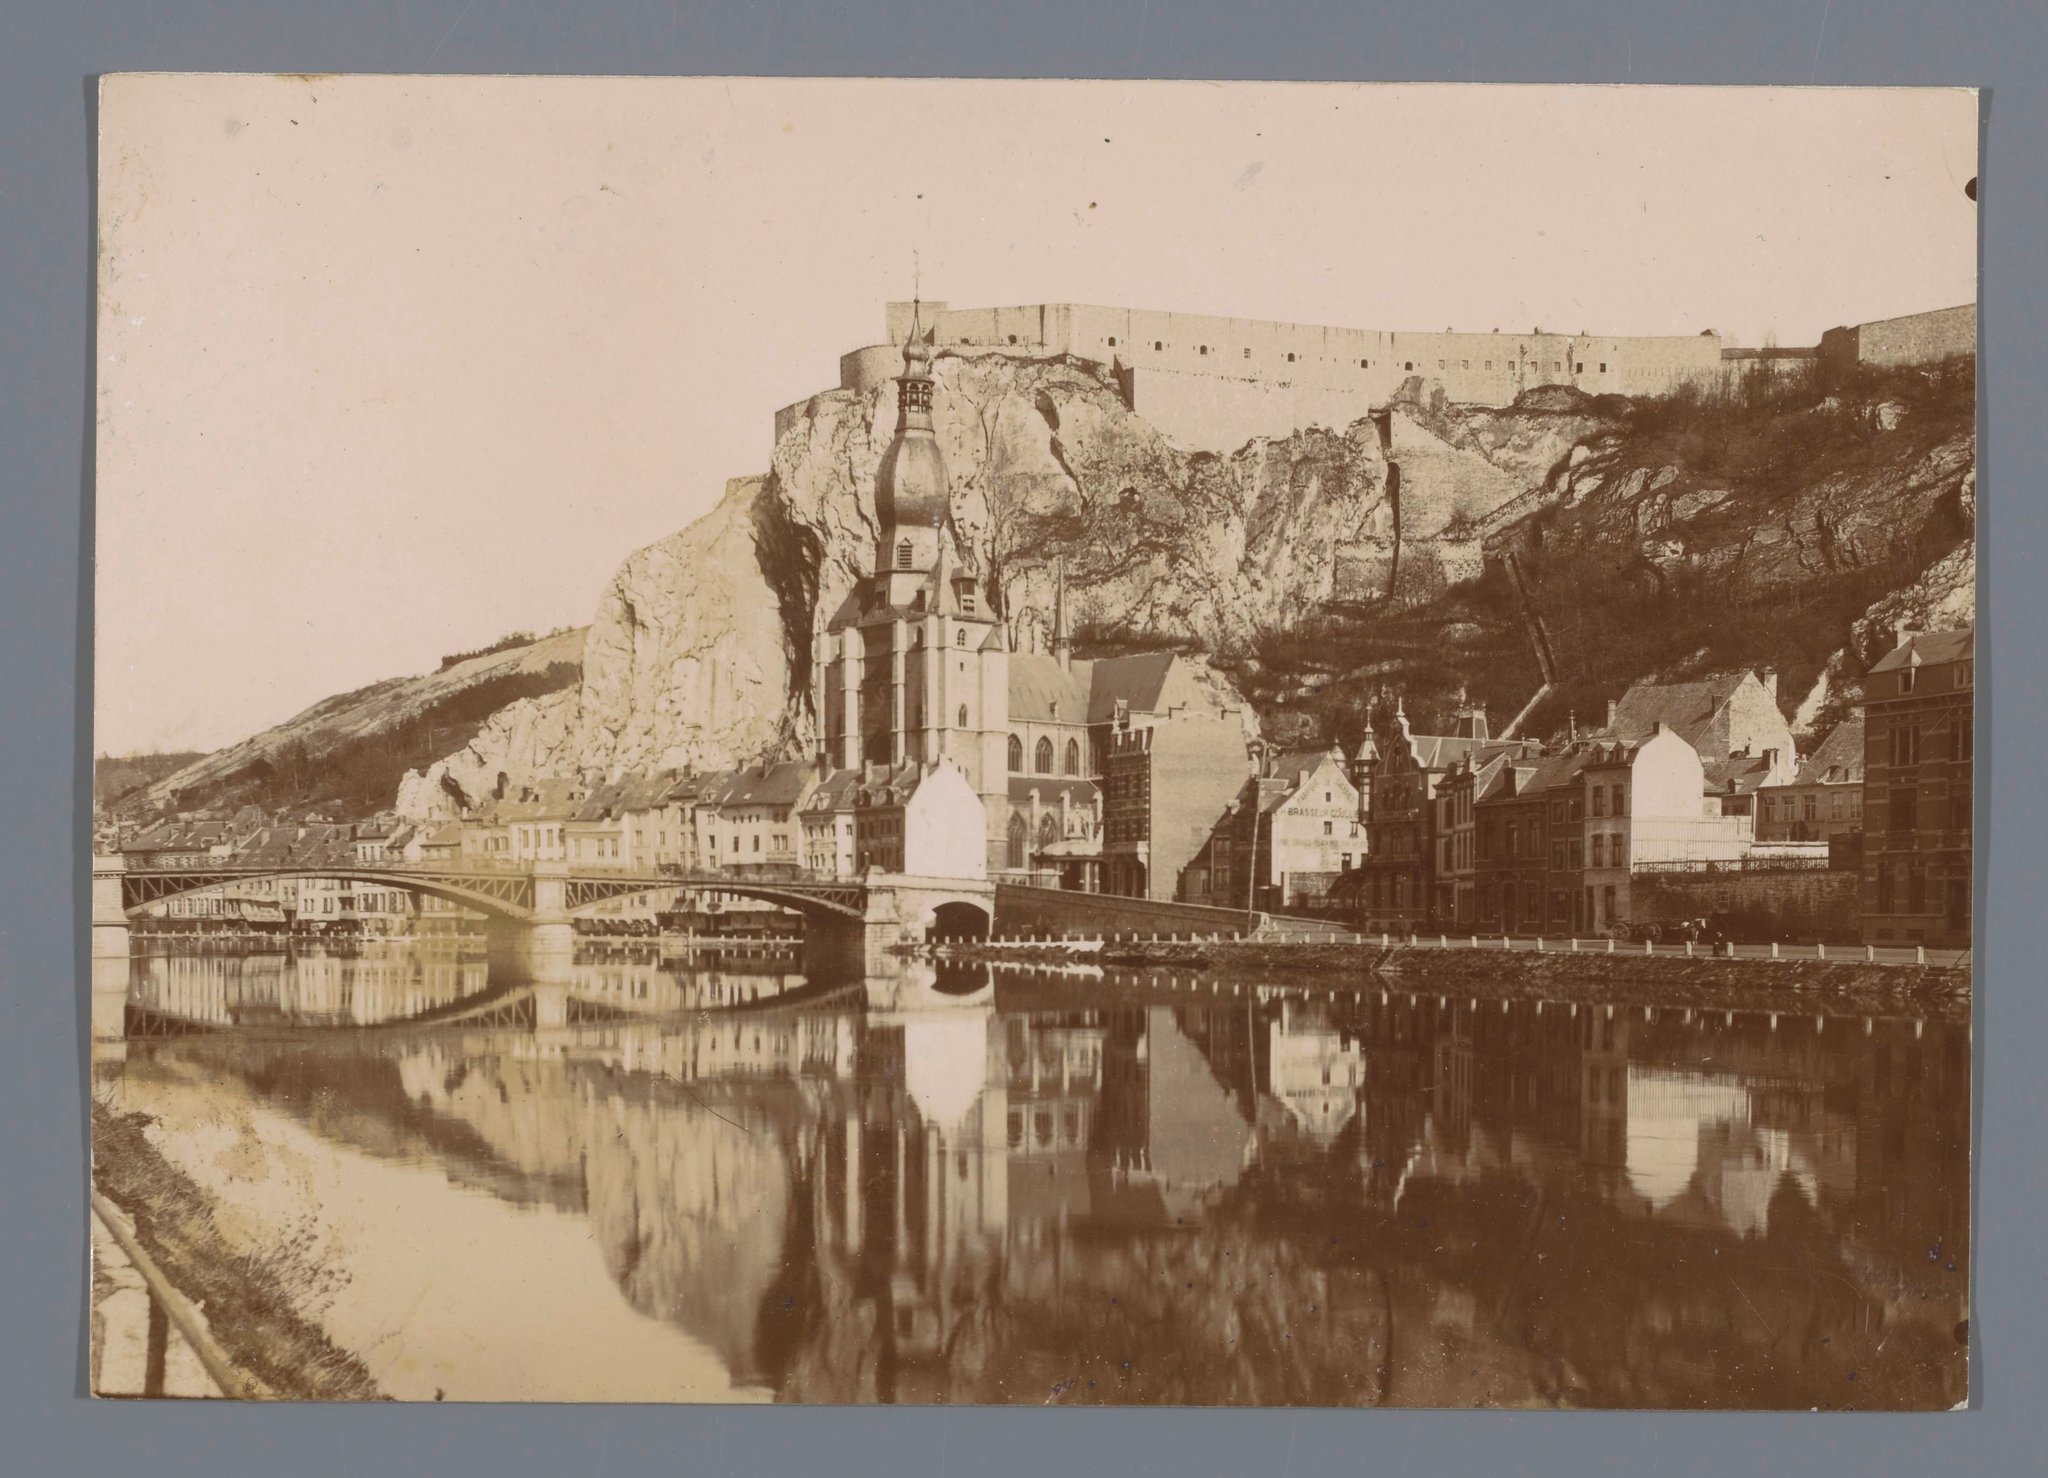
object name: photograph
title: Gezicht op de Maas en de citadel van Dinant, België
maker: Anonymous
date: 1880-1920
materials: photographic support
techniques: gelatin silver print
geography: dinant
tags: fortified city, bridge in city across river, canal, etc.